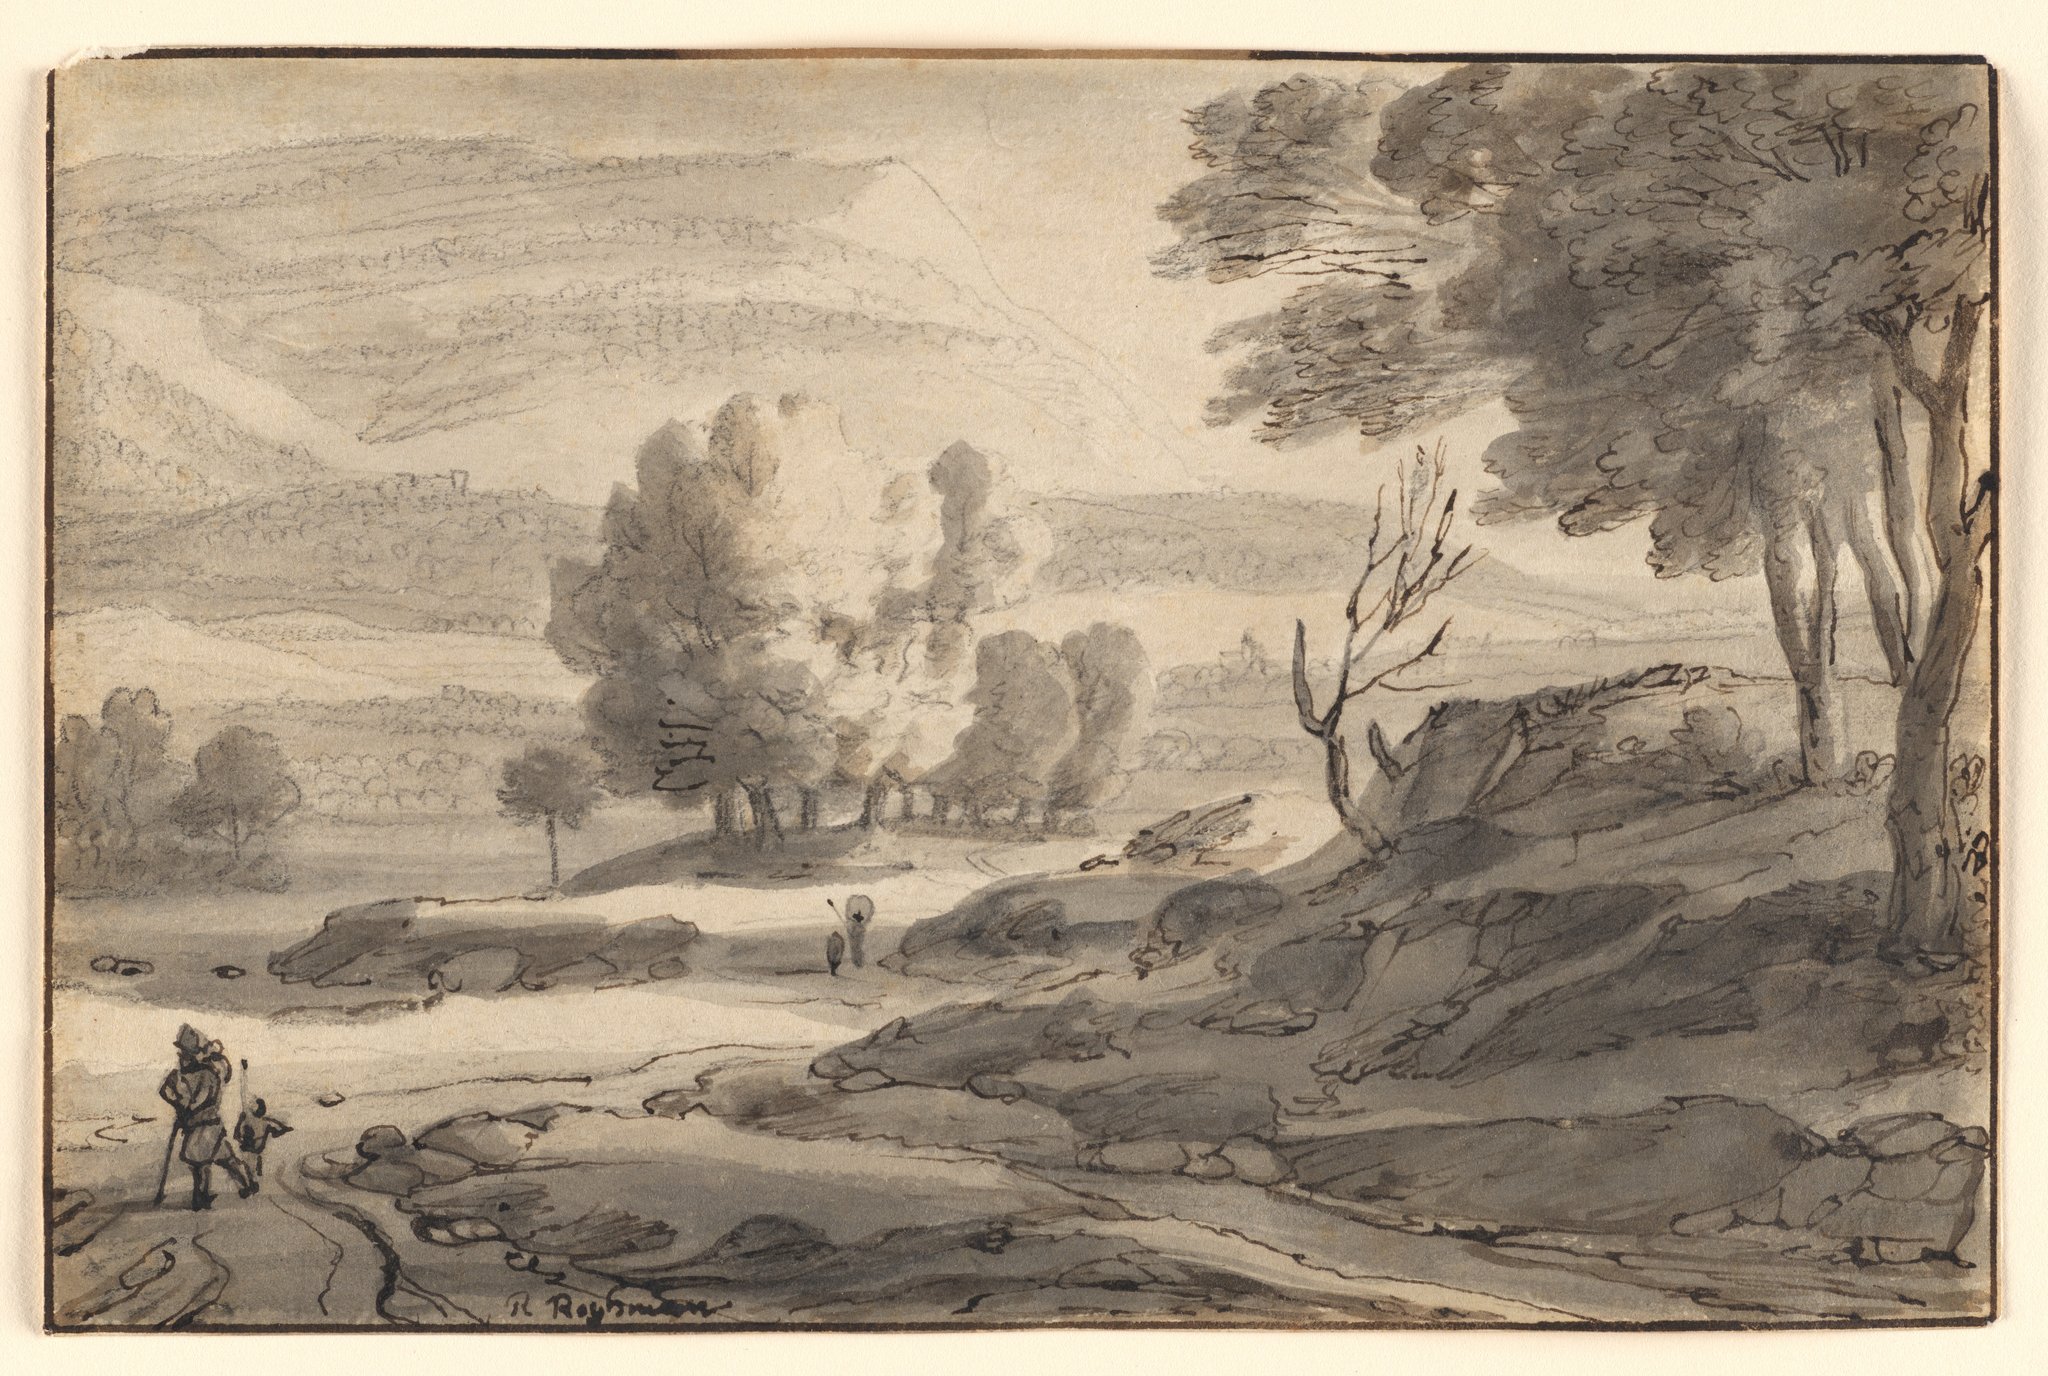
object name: drawing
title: Mountainous River Landscape with Figures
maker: roelant roghman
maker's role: artist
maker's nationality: dutch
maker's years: 1627-1692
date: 1647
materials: chalk, ink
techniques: brush, pen, wash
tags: rivers,landscapes